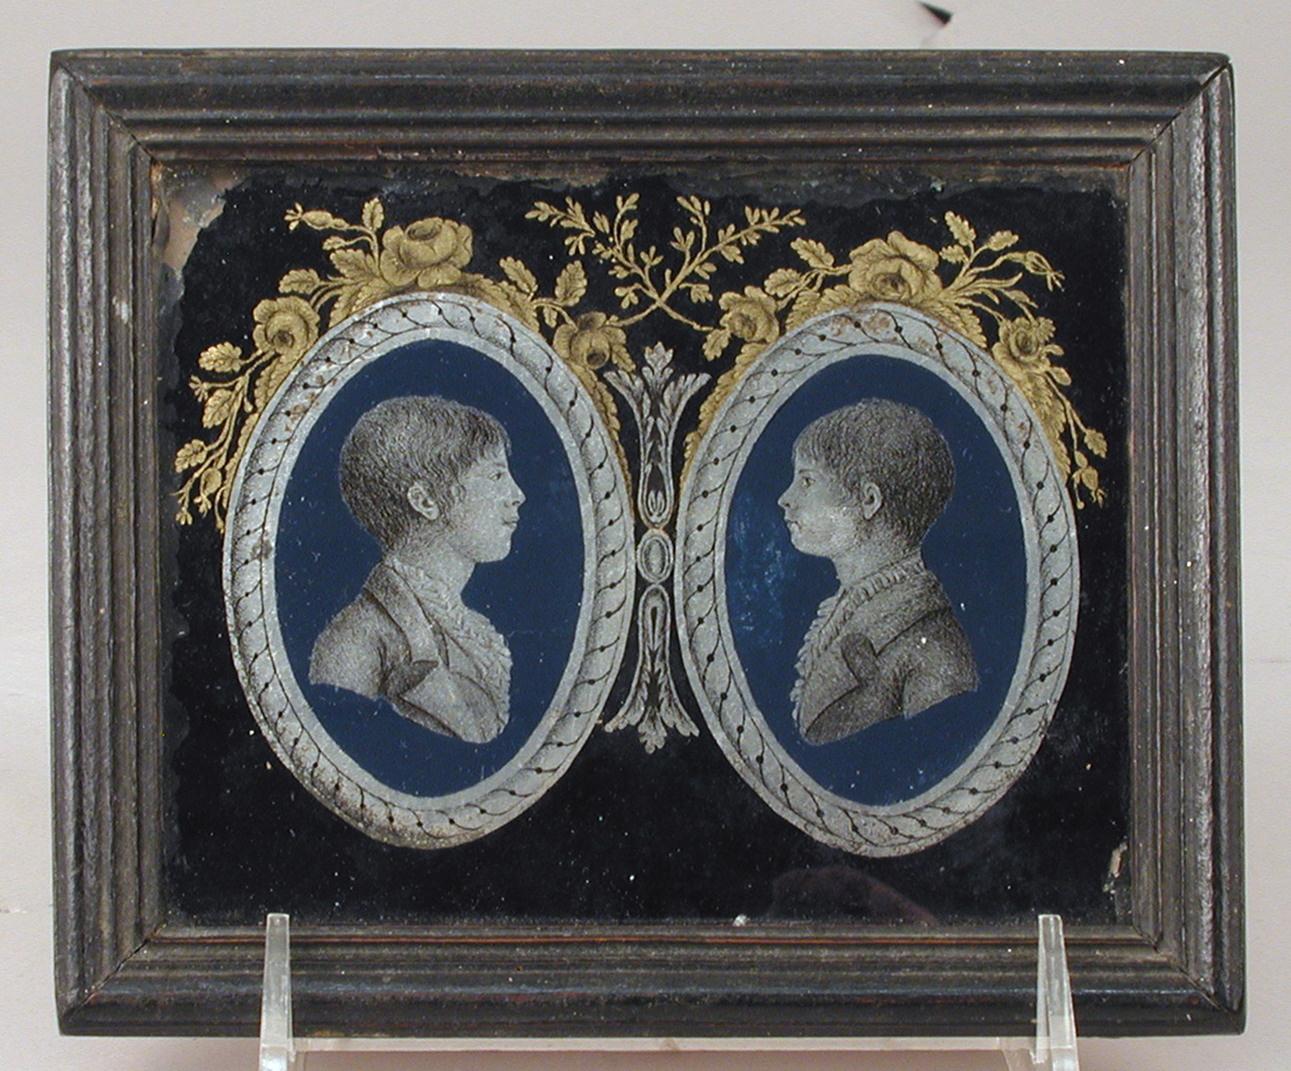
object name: panel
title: Panel with portraits of two boys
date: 1801-1833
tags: boys,profiles